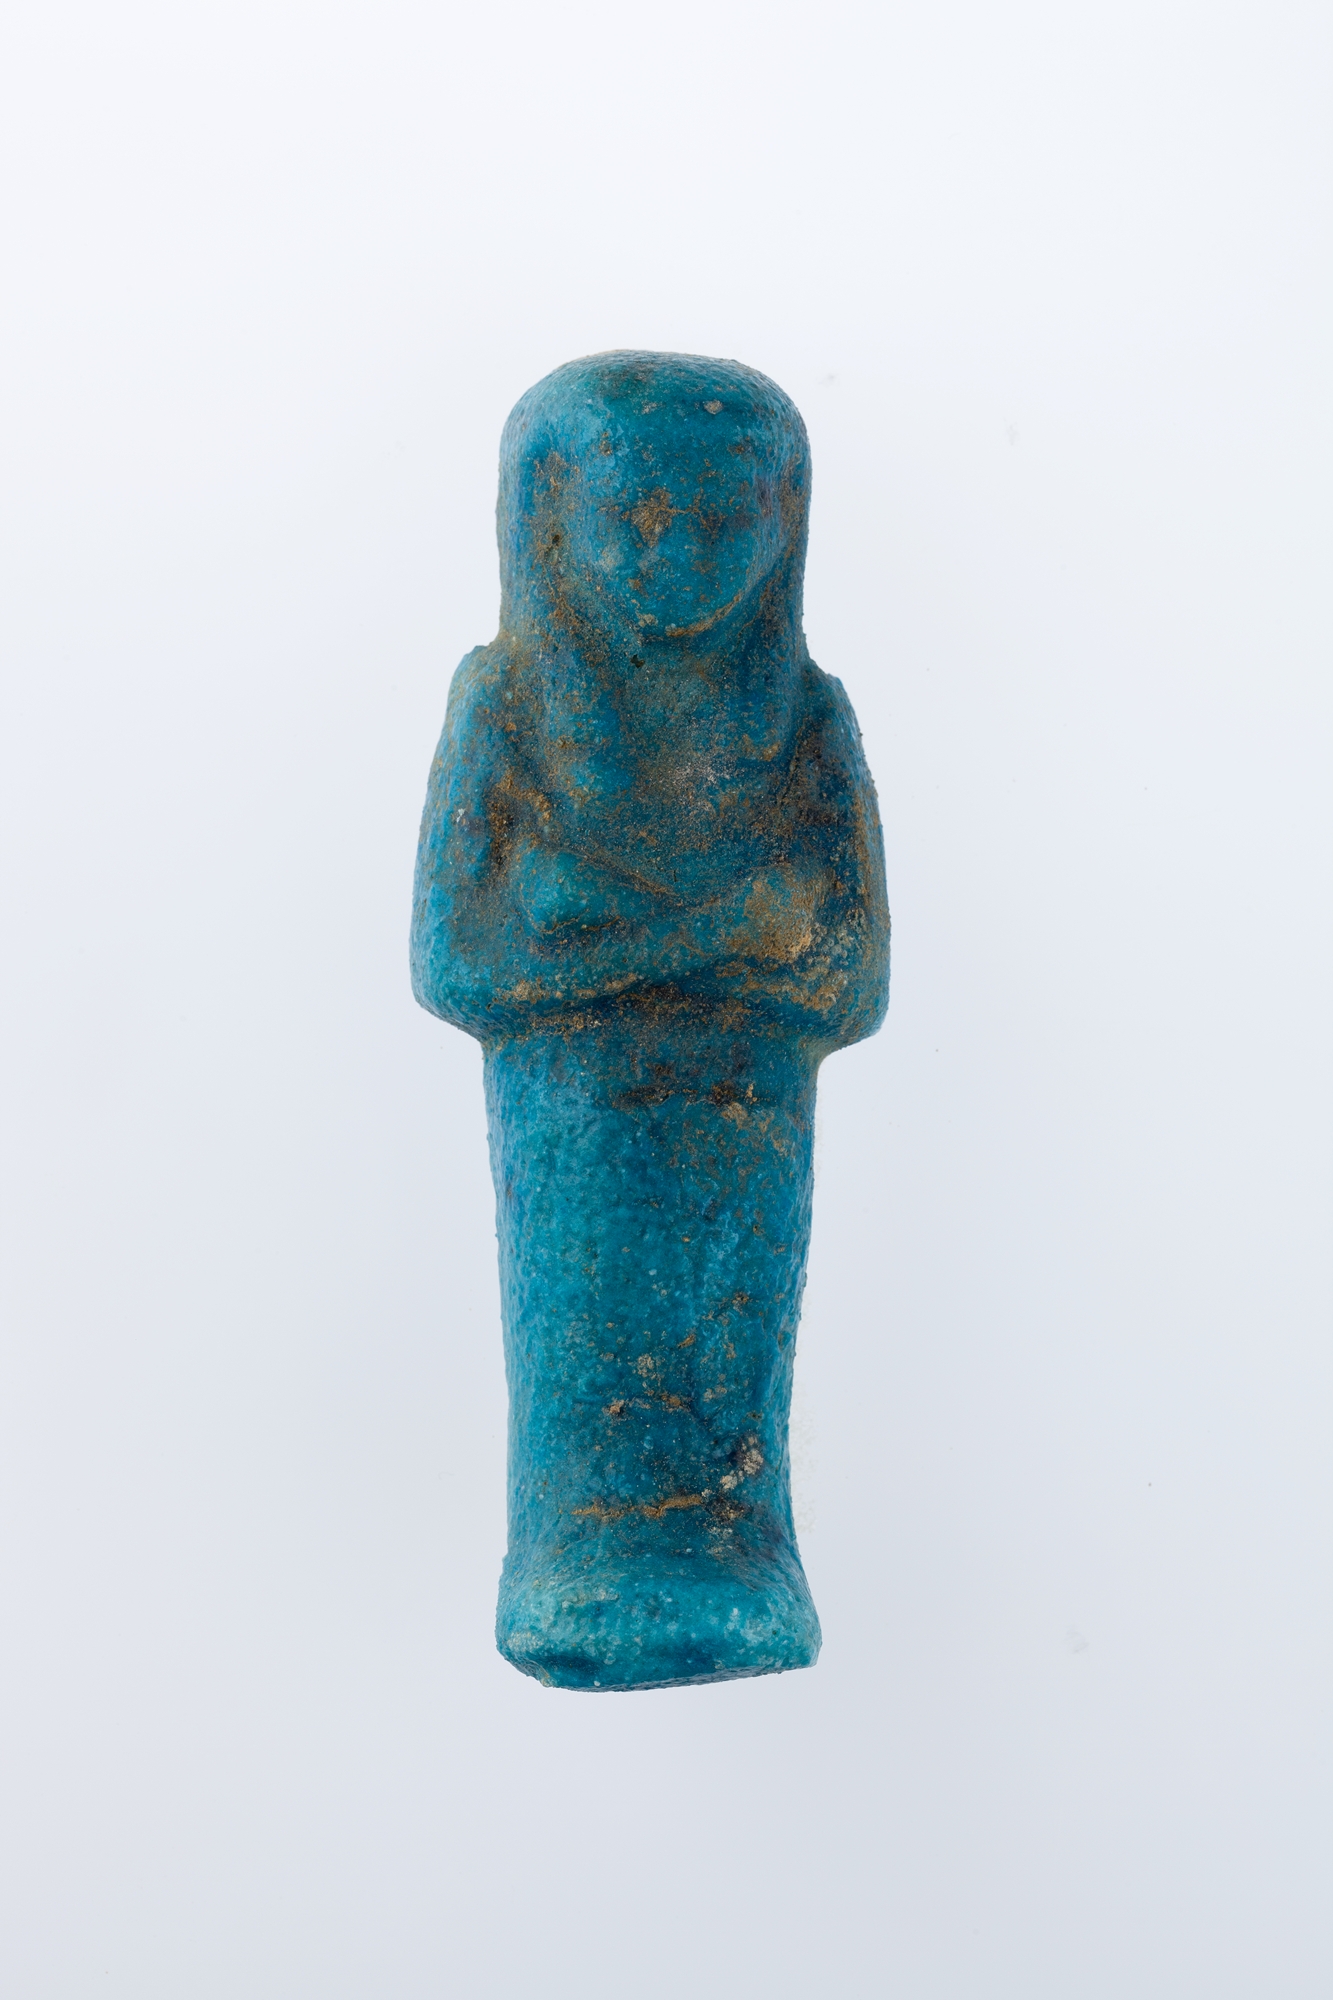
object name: shabti, henettawy c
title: Worker Shabti of Henettawy (C), Daughter of Isetemkheb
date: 990-970 BCE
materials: faience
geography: egypt